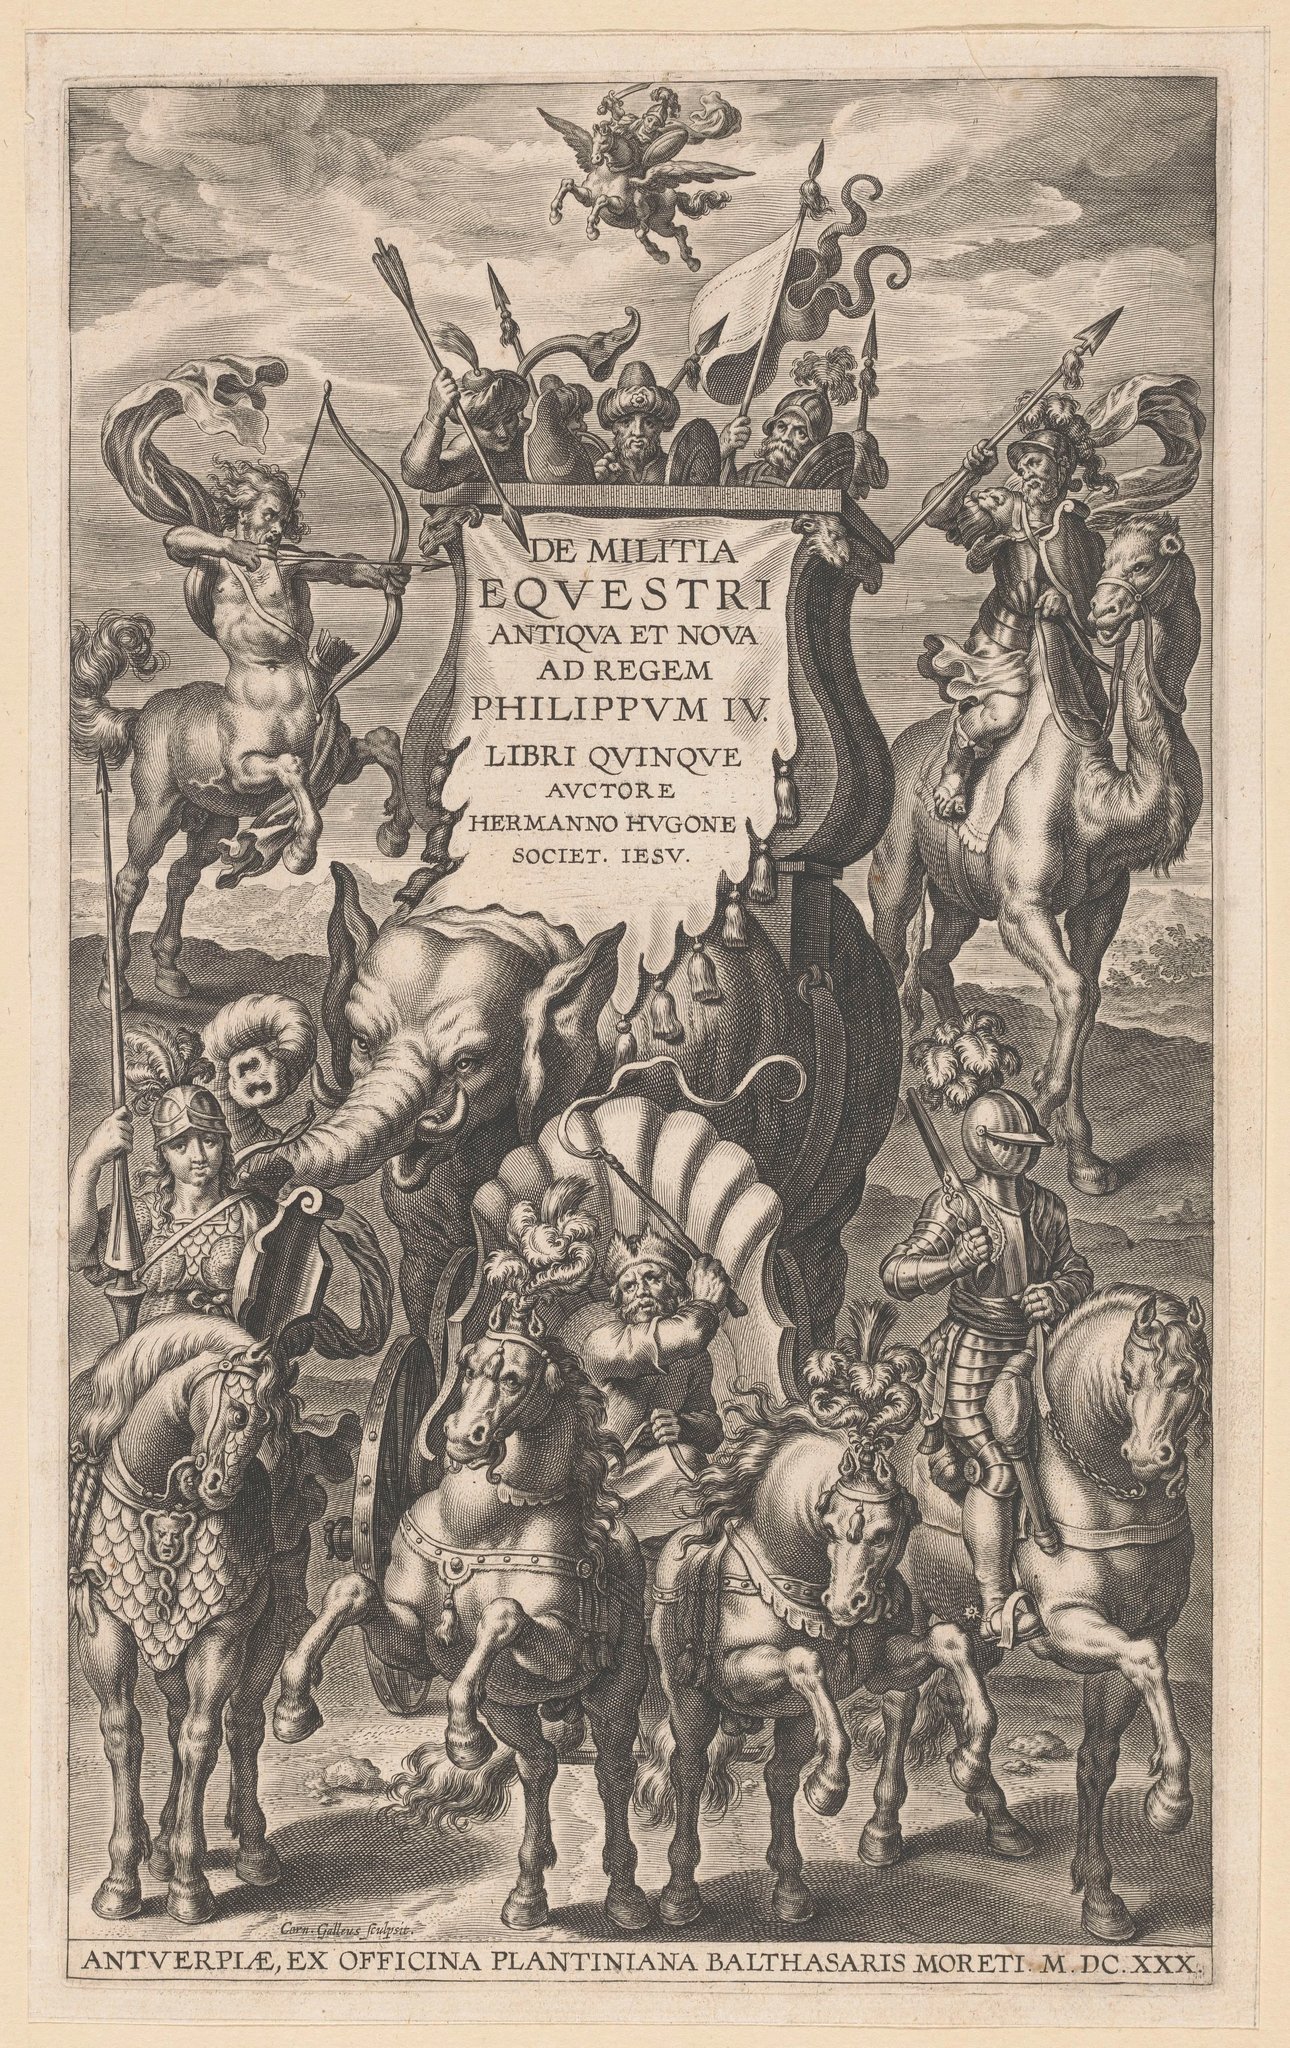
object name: print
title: Titelpagina voor: H. Hugo, De militia equestri antiqua et nova ad regem Philippum IV, Antwerpen, 1630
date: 1630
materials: paper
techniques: engraving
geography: southern netherlands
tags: military discipline (+ cavalry, horsemen), military discipline (+ mounted troops on other animals than horses)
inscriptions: collector's mark: Lugt 240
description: Titelpagina voor een boek over krijgsvoering te paard. Op de voorgrond Minerva te paard, een koets met twee paarden en een ridder te paard. Erachter een olifant die soldaten in een bak vervoert. Rechts een soldaat op een kameel en links een centaur.